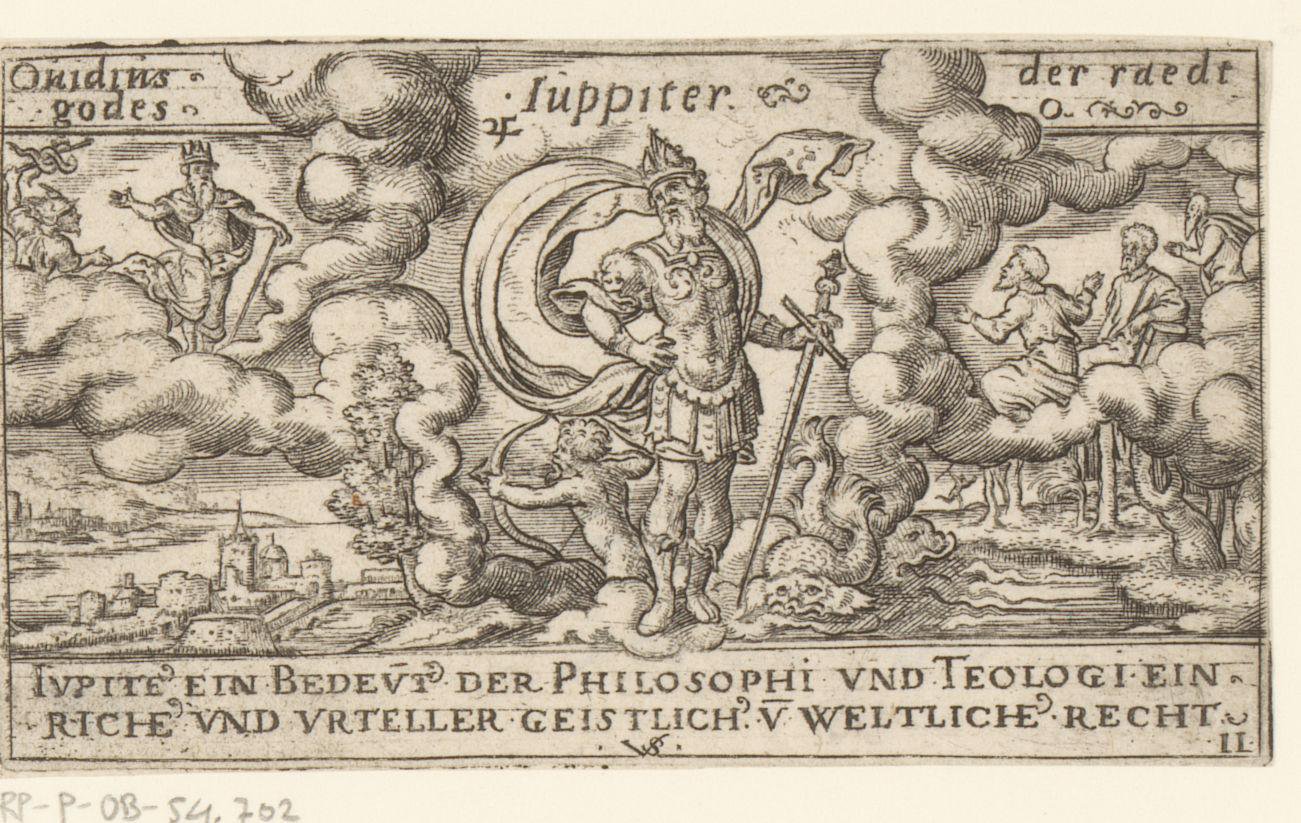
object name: print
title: Jupiter met een Boogschutter en Vissen (tekens van de dierenriem)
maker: virgilius solis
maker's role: draughtsman, print maker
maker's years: 1514-1562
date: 1524-1562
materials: paper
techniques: engraving, etching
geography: nuremberg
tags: (story of) mercury (hermes), (story of) jupiter (zeus), pisces (zodiacal sign of february), sagittarius (zodiacal sign of november), jupiter (planet)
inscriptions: number: ‘52’, collector's mark: Lugt 2228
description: Maakt deel uit van een serie van zeven prenten met personificaties van de planeten, tekens van de dierenriem en verbeeldingen van verhalen uit de Metamorfosen van Ovidius.